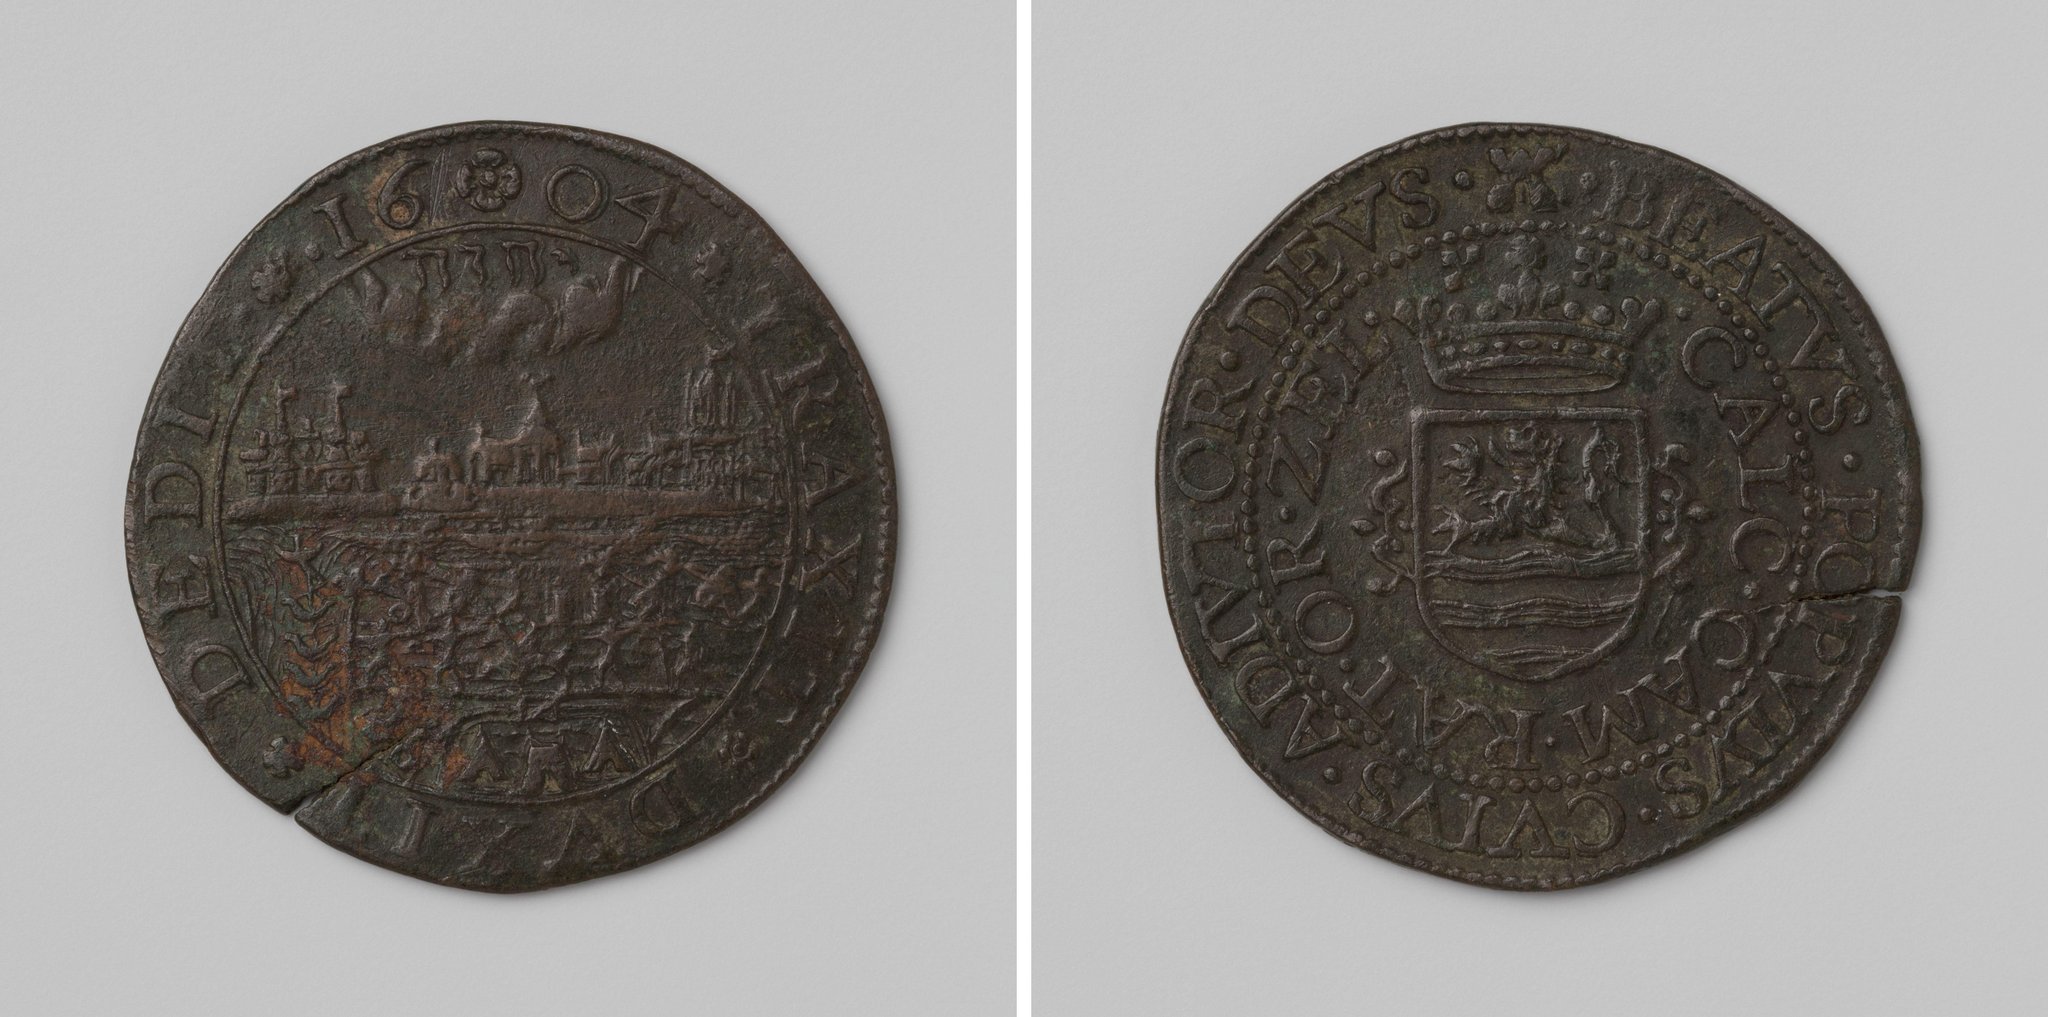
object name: jeton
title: Inname van Sluis met haven en vloot, rekenpenning van de rekenkamer van Zeeland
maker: Anonymous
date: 1604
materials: copper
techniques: striking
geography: middelburg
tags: zeeland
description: Koperen penning. Voorzijde: gezicht op stad Sluis, haven, havenwerken en veroverde schepen; daarboven naam Jehova in Hebreeuws schrift in wolken binnen omschrift. Keerzijde: gekroond wapenschild binnen tweeregelig omschrift